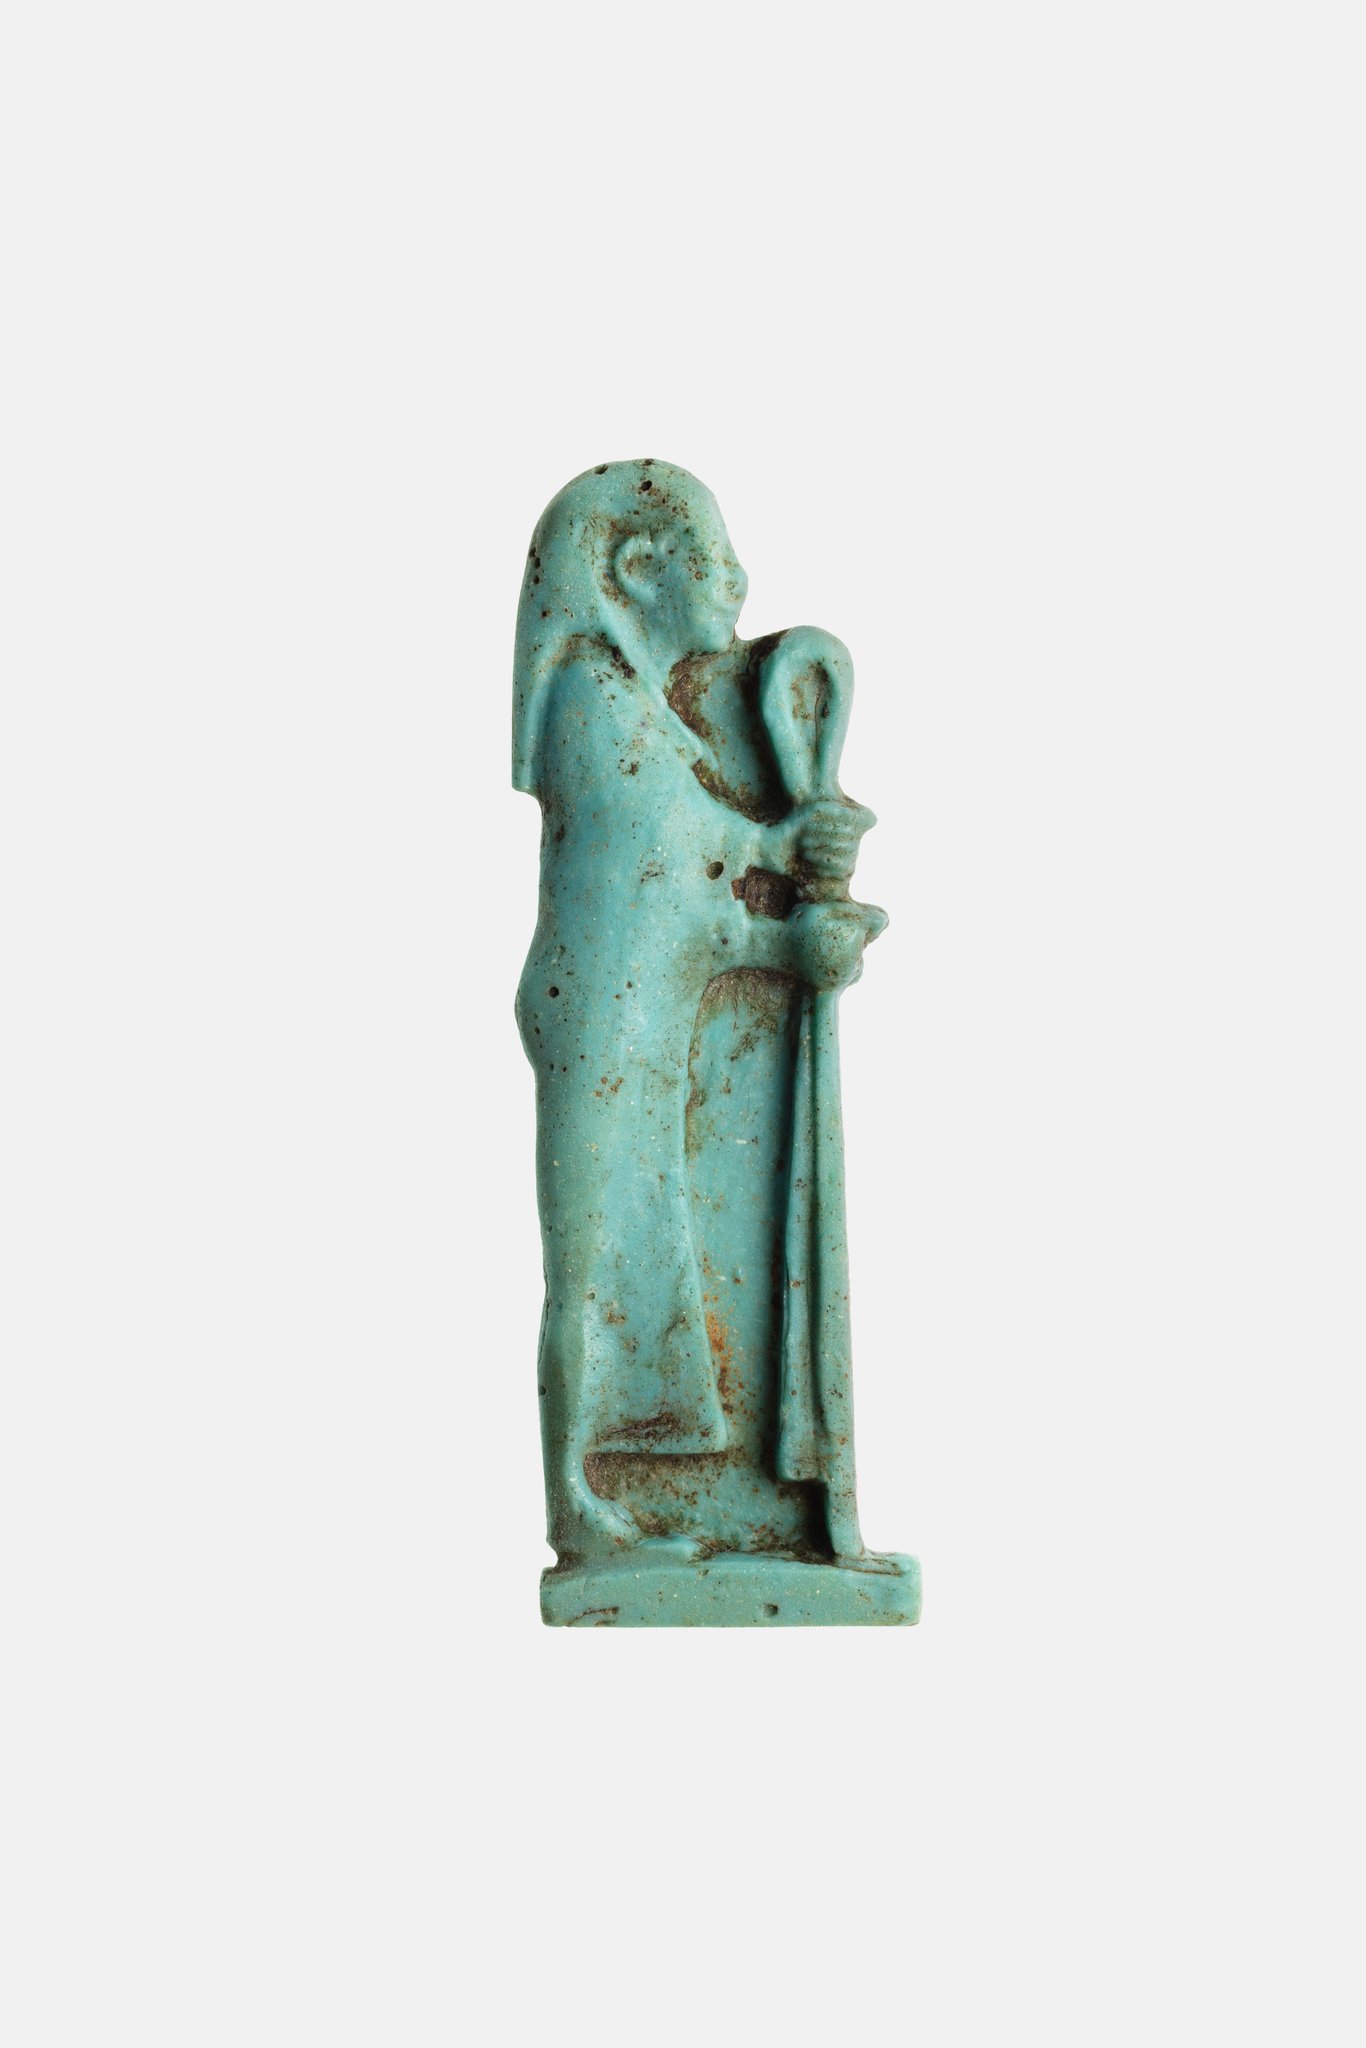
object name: amulet, four son of horus, imseti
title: Funerary amulet depicting one of the Four Sons of Horus, Imseti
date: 332-330 BCE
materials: glass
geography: egypt